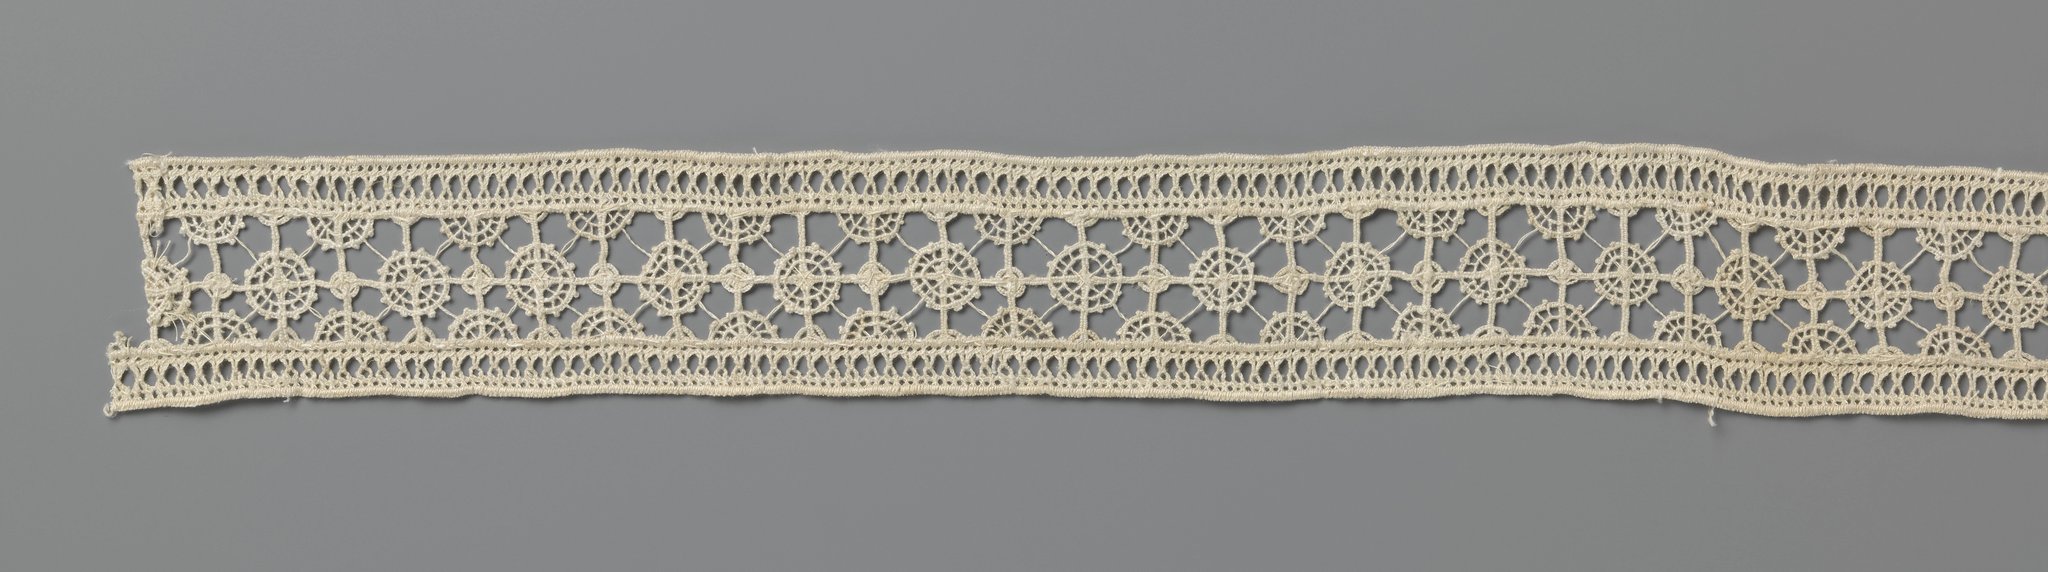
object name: strip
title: Strook naaldkant met kleine dichte en grote open cirkels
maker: Anonymous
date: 1900-1949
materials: cotton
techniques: needle lace, openwork embroidery, reticella, work with drawn threads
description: Strook naturelkleurige naaldkant - reticella - tussen randen open naaiwerk: werk met uitgetrokken draden. Het zich herhalende en symmetrische patroon bestaat uit één rij vierkanten, die zijn opgebouwd uit vier kleine vierkanten. Elk groot vierkant is doorkruisd, op elk kruispunt om en om een kleine dichtgewerkte en een grote opengewerkte cirkel. Langs de randen halve cirkels. De boven- en onderzijde van de strook zijn recht afgewerkt met open ruitjes (werk met uitgetrokken draden).